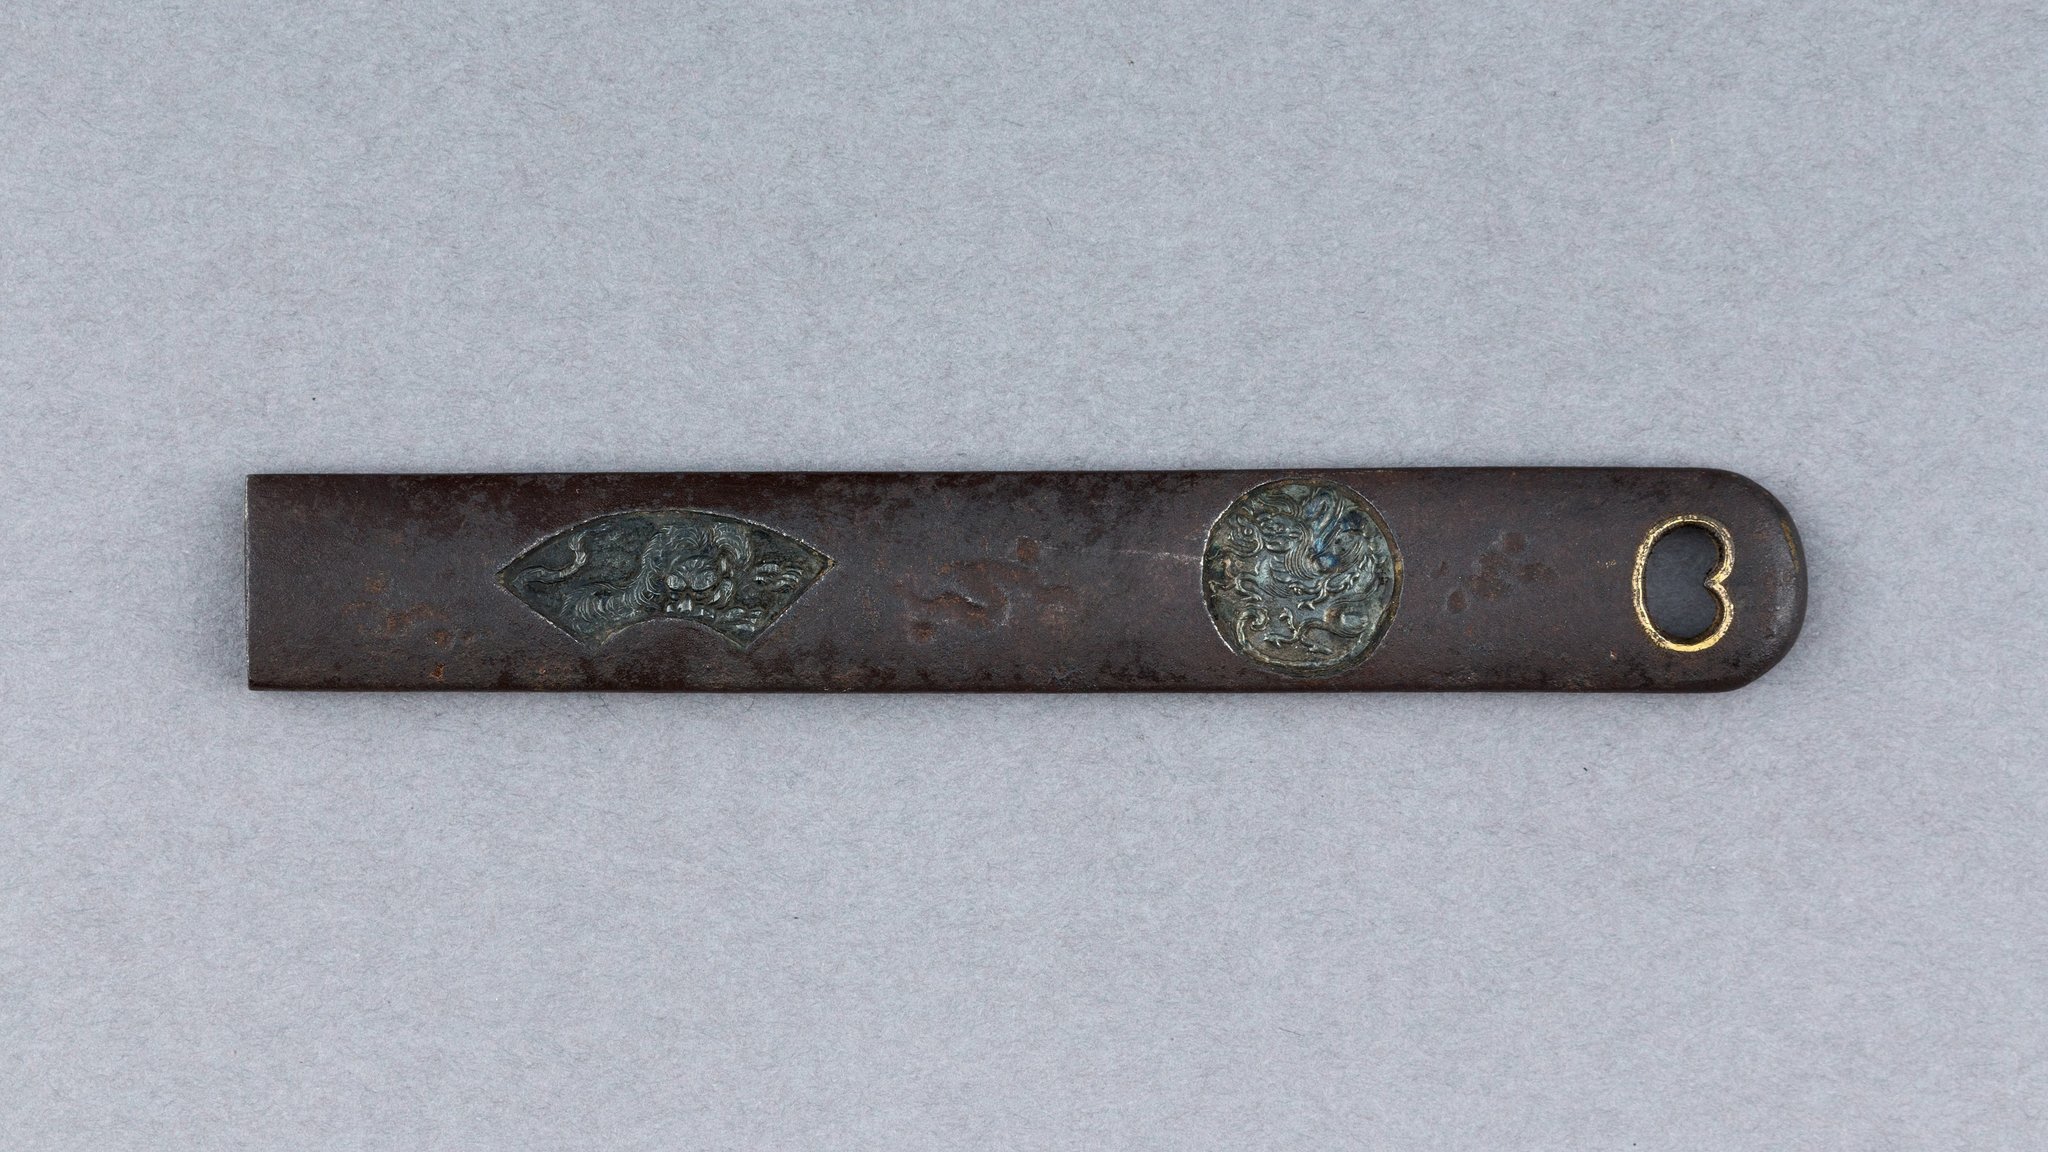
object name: knife handle kozuka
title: Knife Handle (Kozuka)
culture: japanese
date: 1615-1868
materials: silver alloy, iron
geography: japan